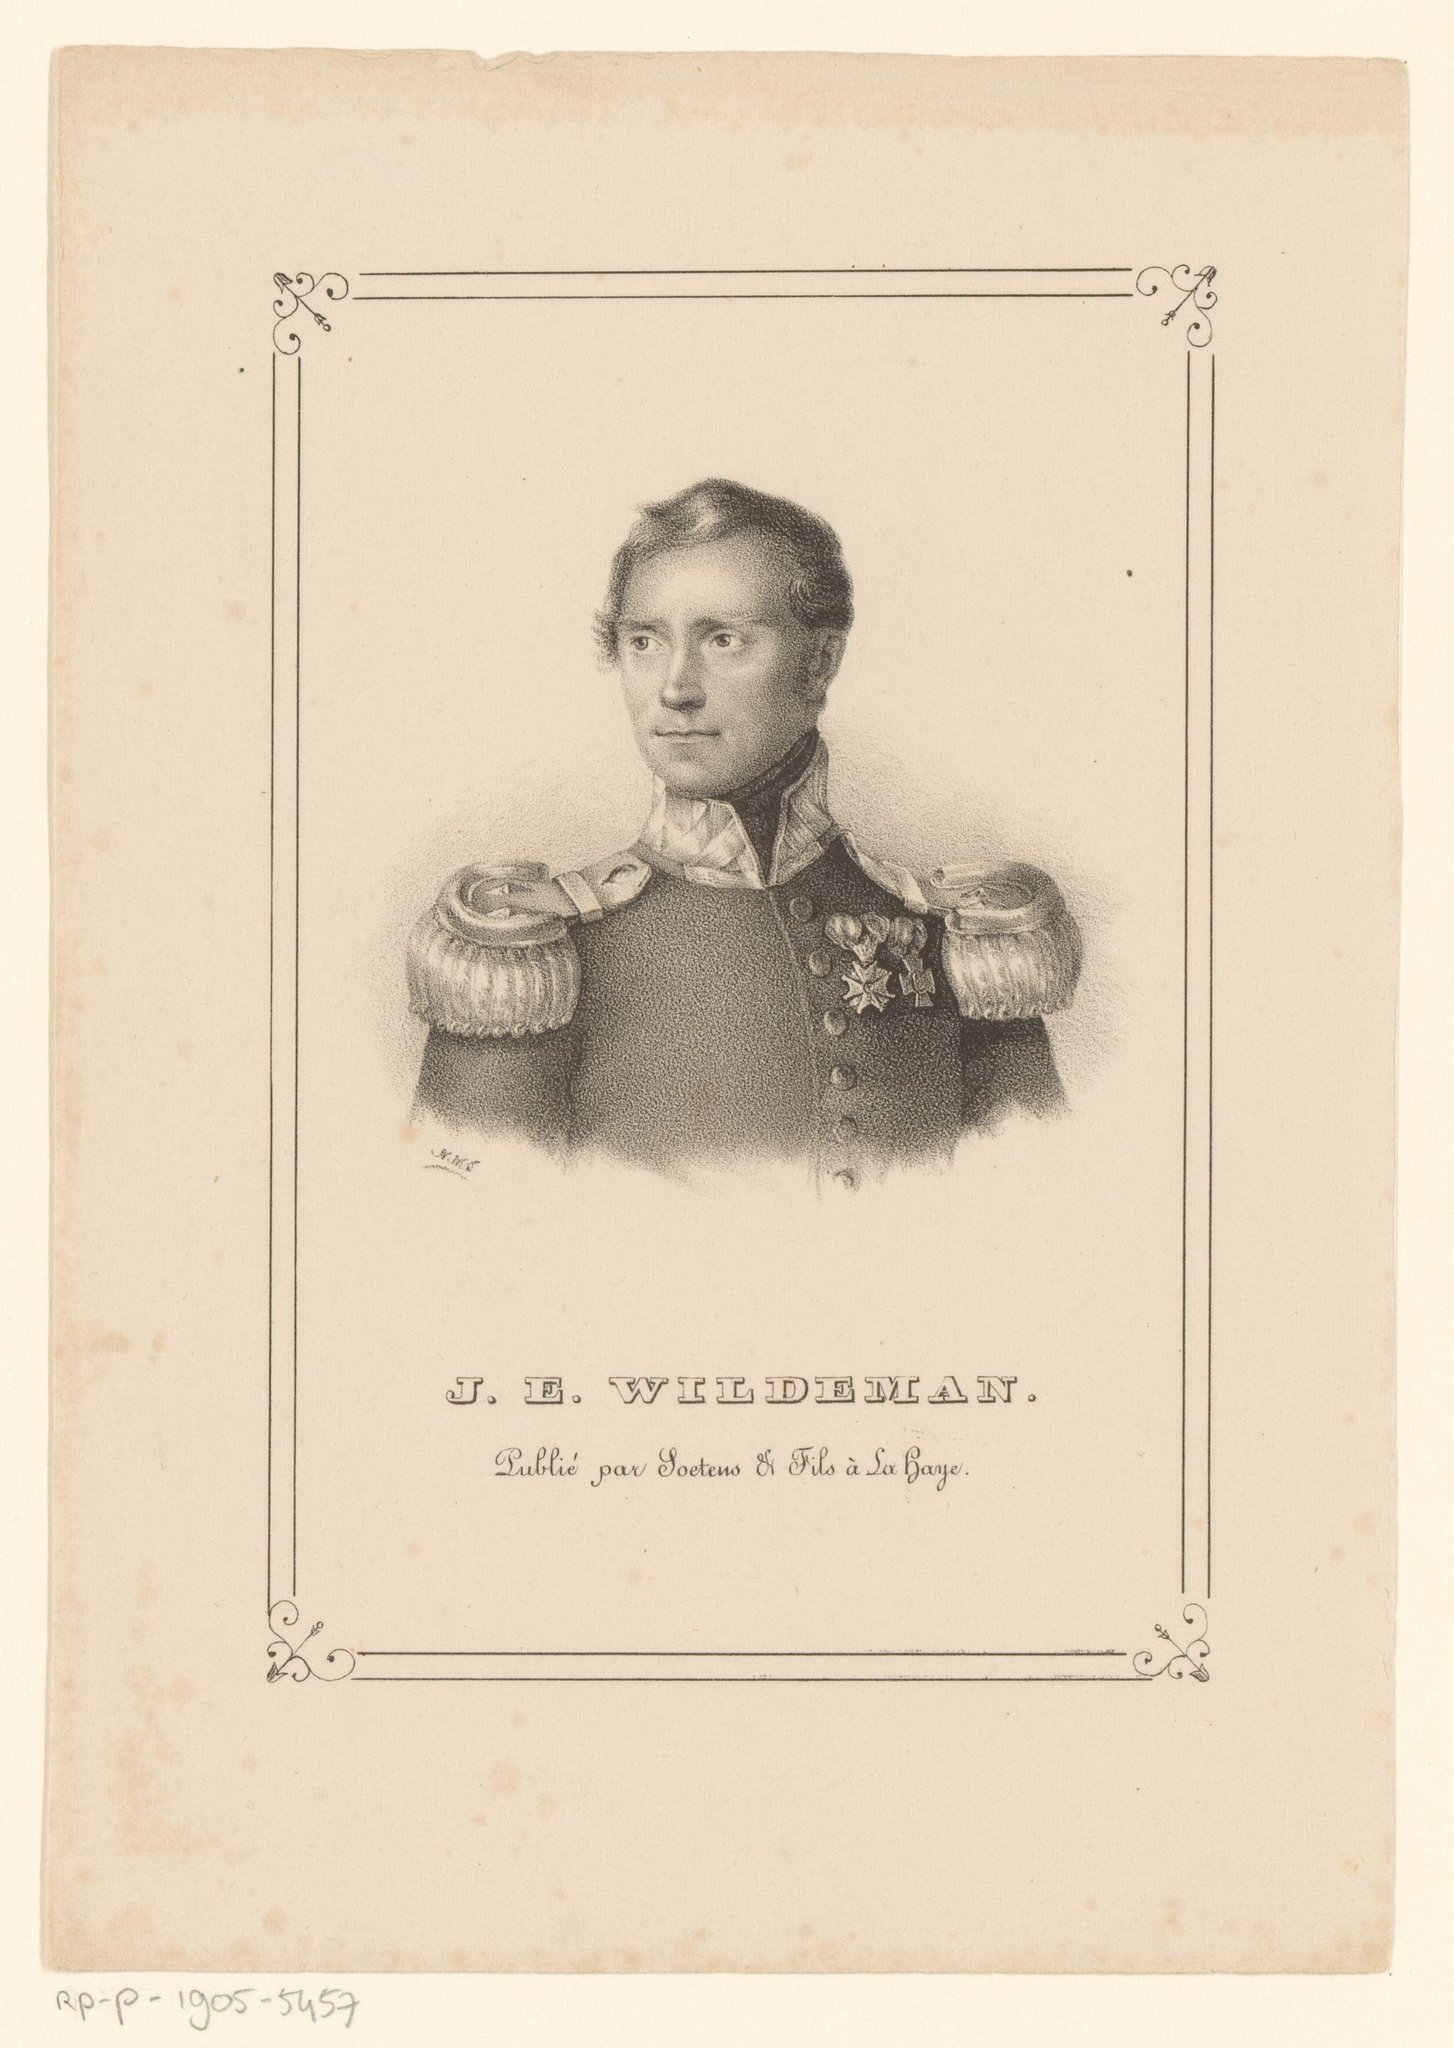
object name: print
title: Portret van Jan Ernst Wildeman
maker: nicolaas martinus schild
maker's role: draughtsman, print maker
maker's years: 1822-1840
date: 1837-1840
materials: paper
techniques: lithograph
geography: the hague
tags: harlingen, historical persons (+ (full) bust portrait)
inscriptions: collector's mark: Lugt 2228